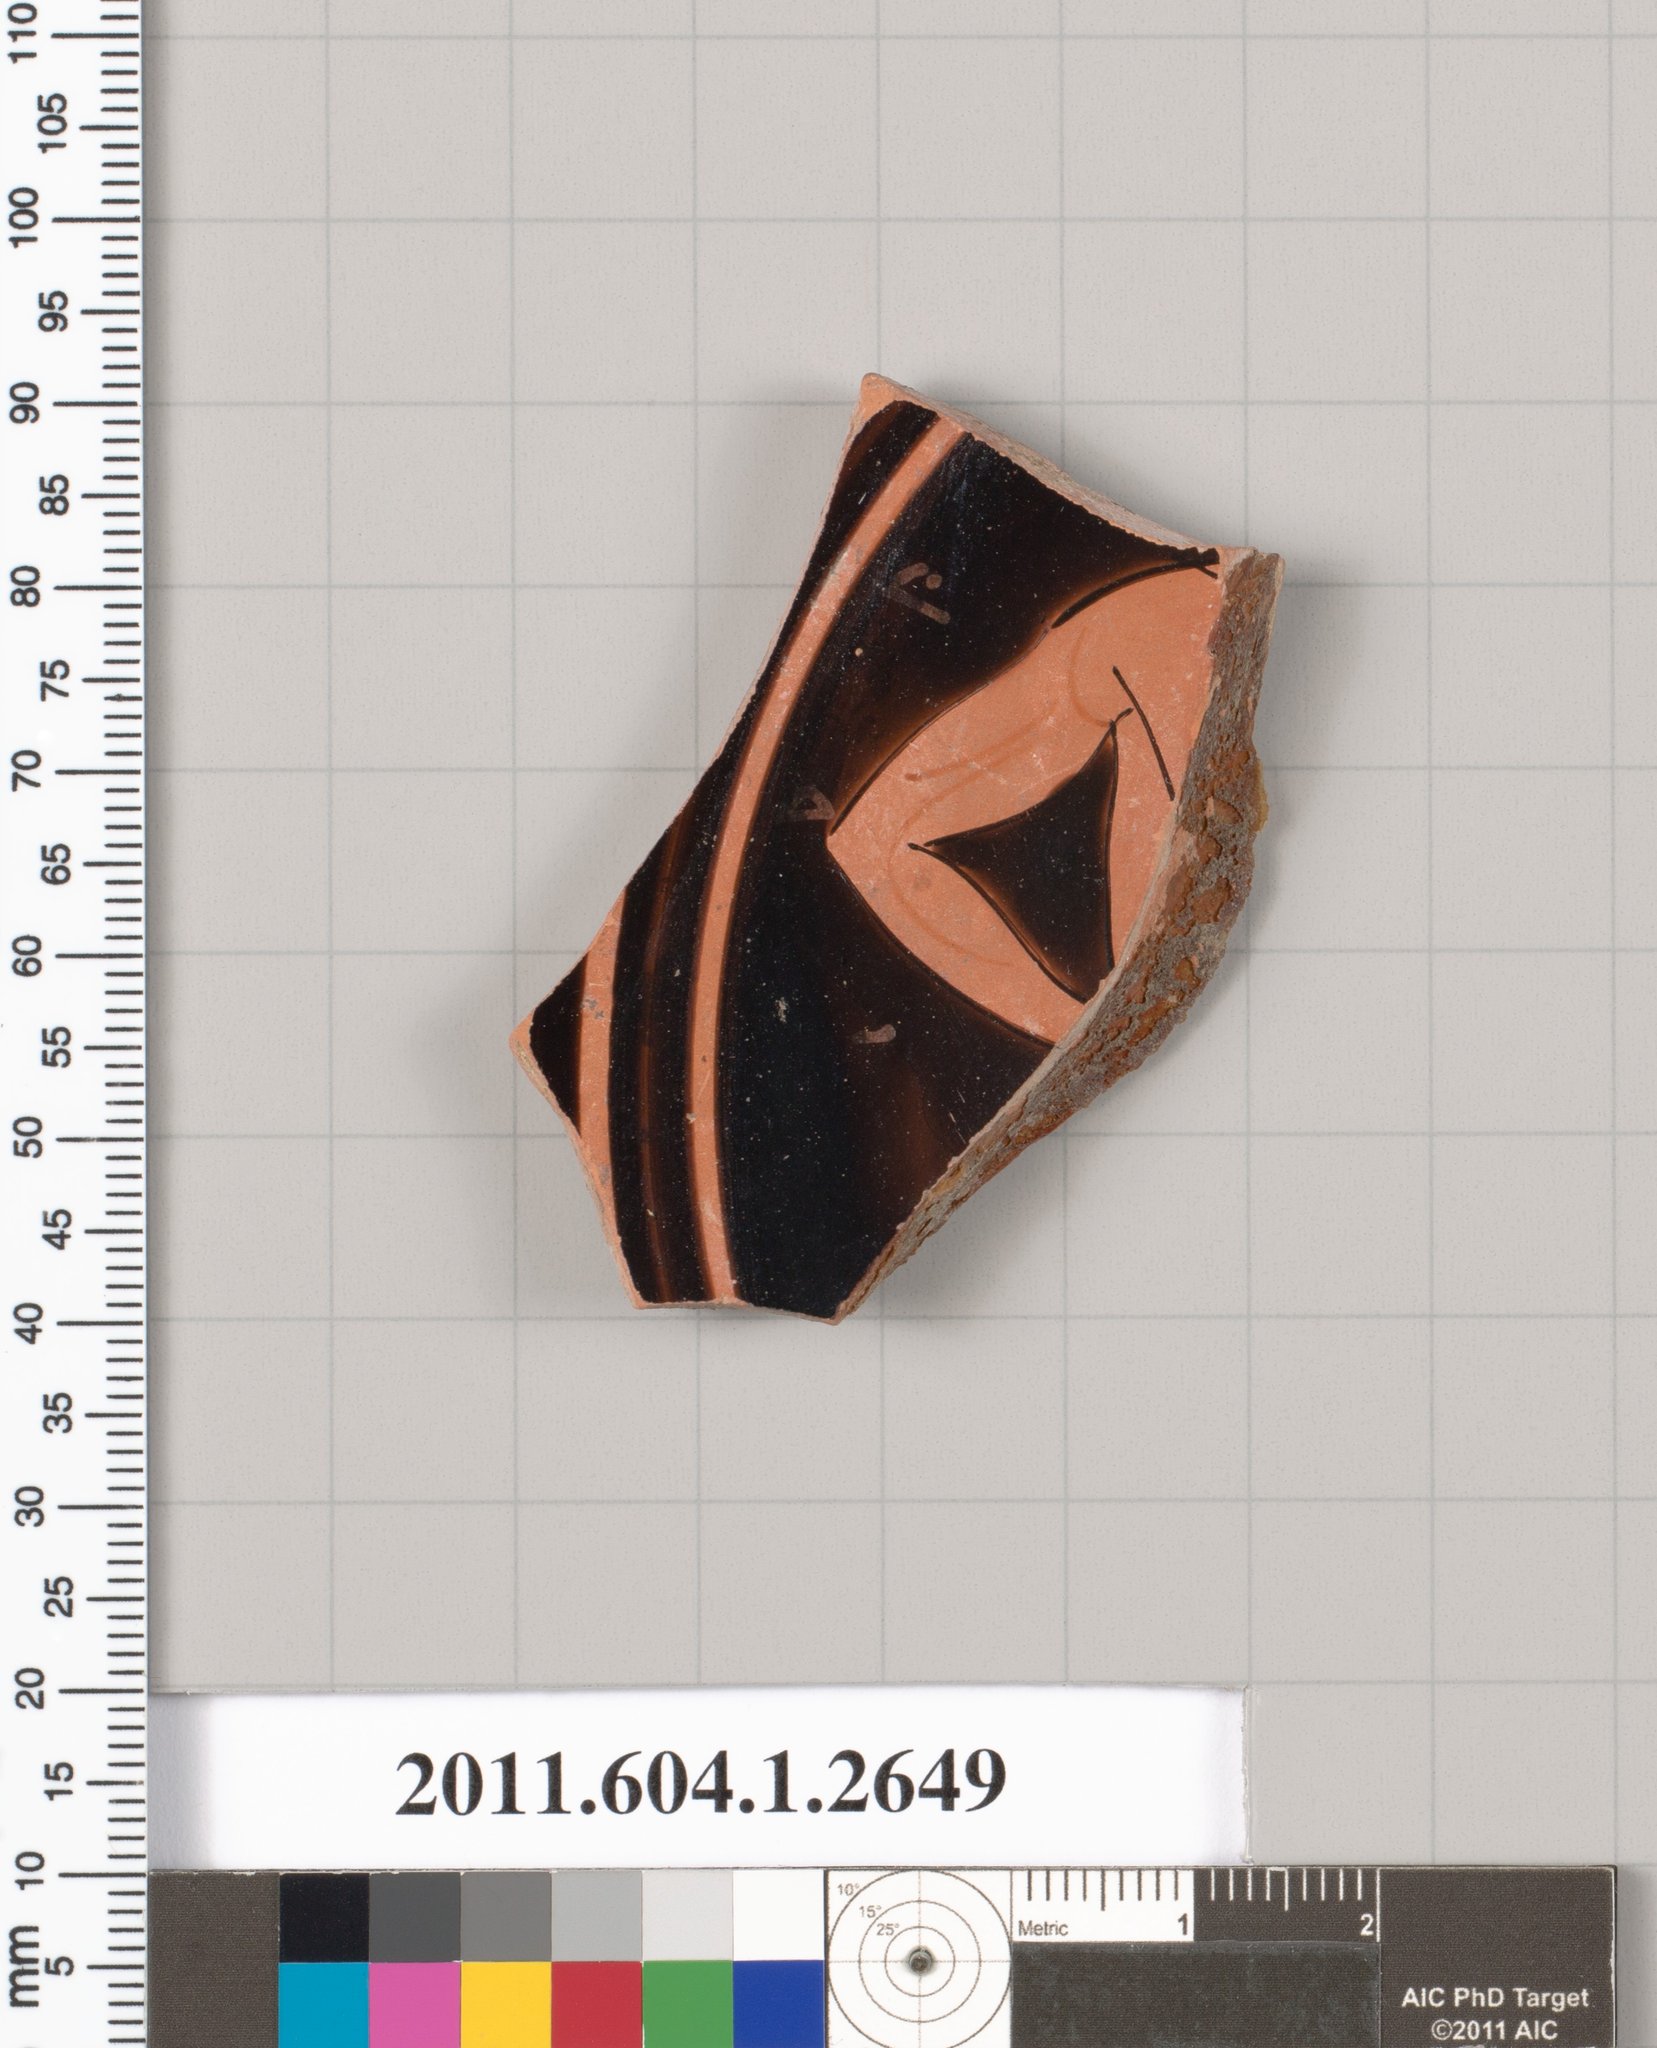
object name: kylix fragment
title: Terracotta fragment of a kylix (drinking cup)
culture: greek, attic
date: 520-500 BCE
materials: terracotta